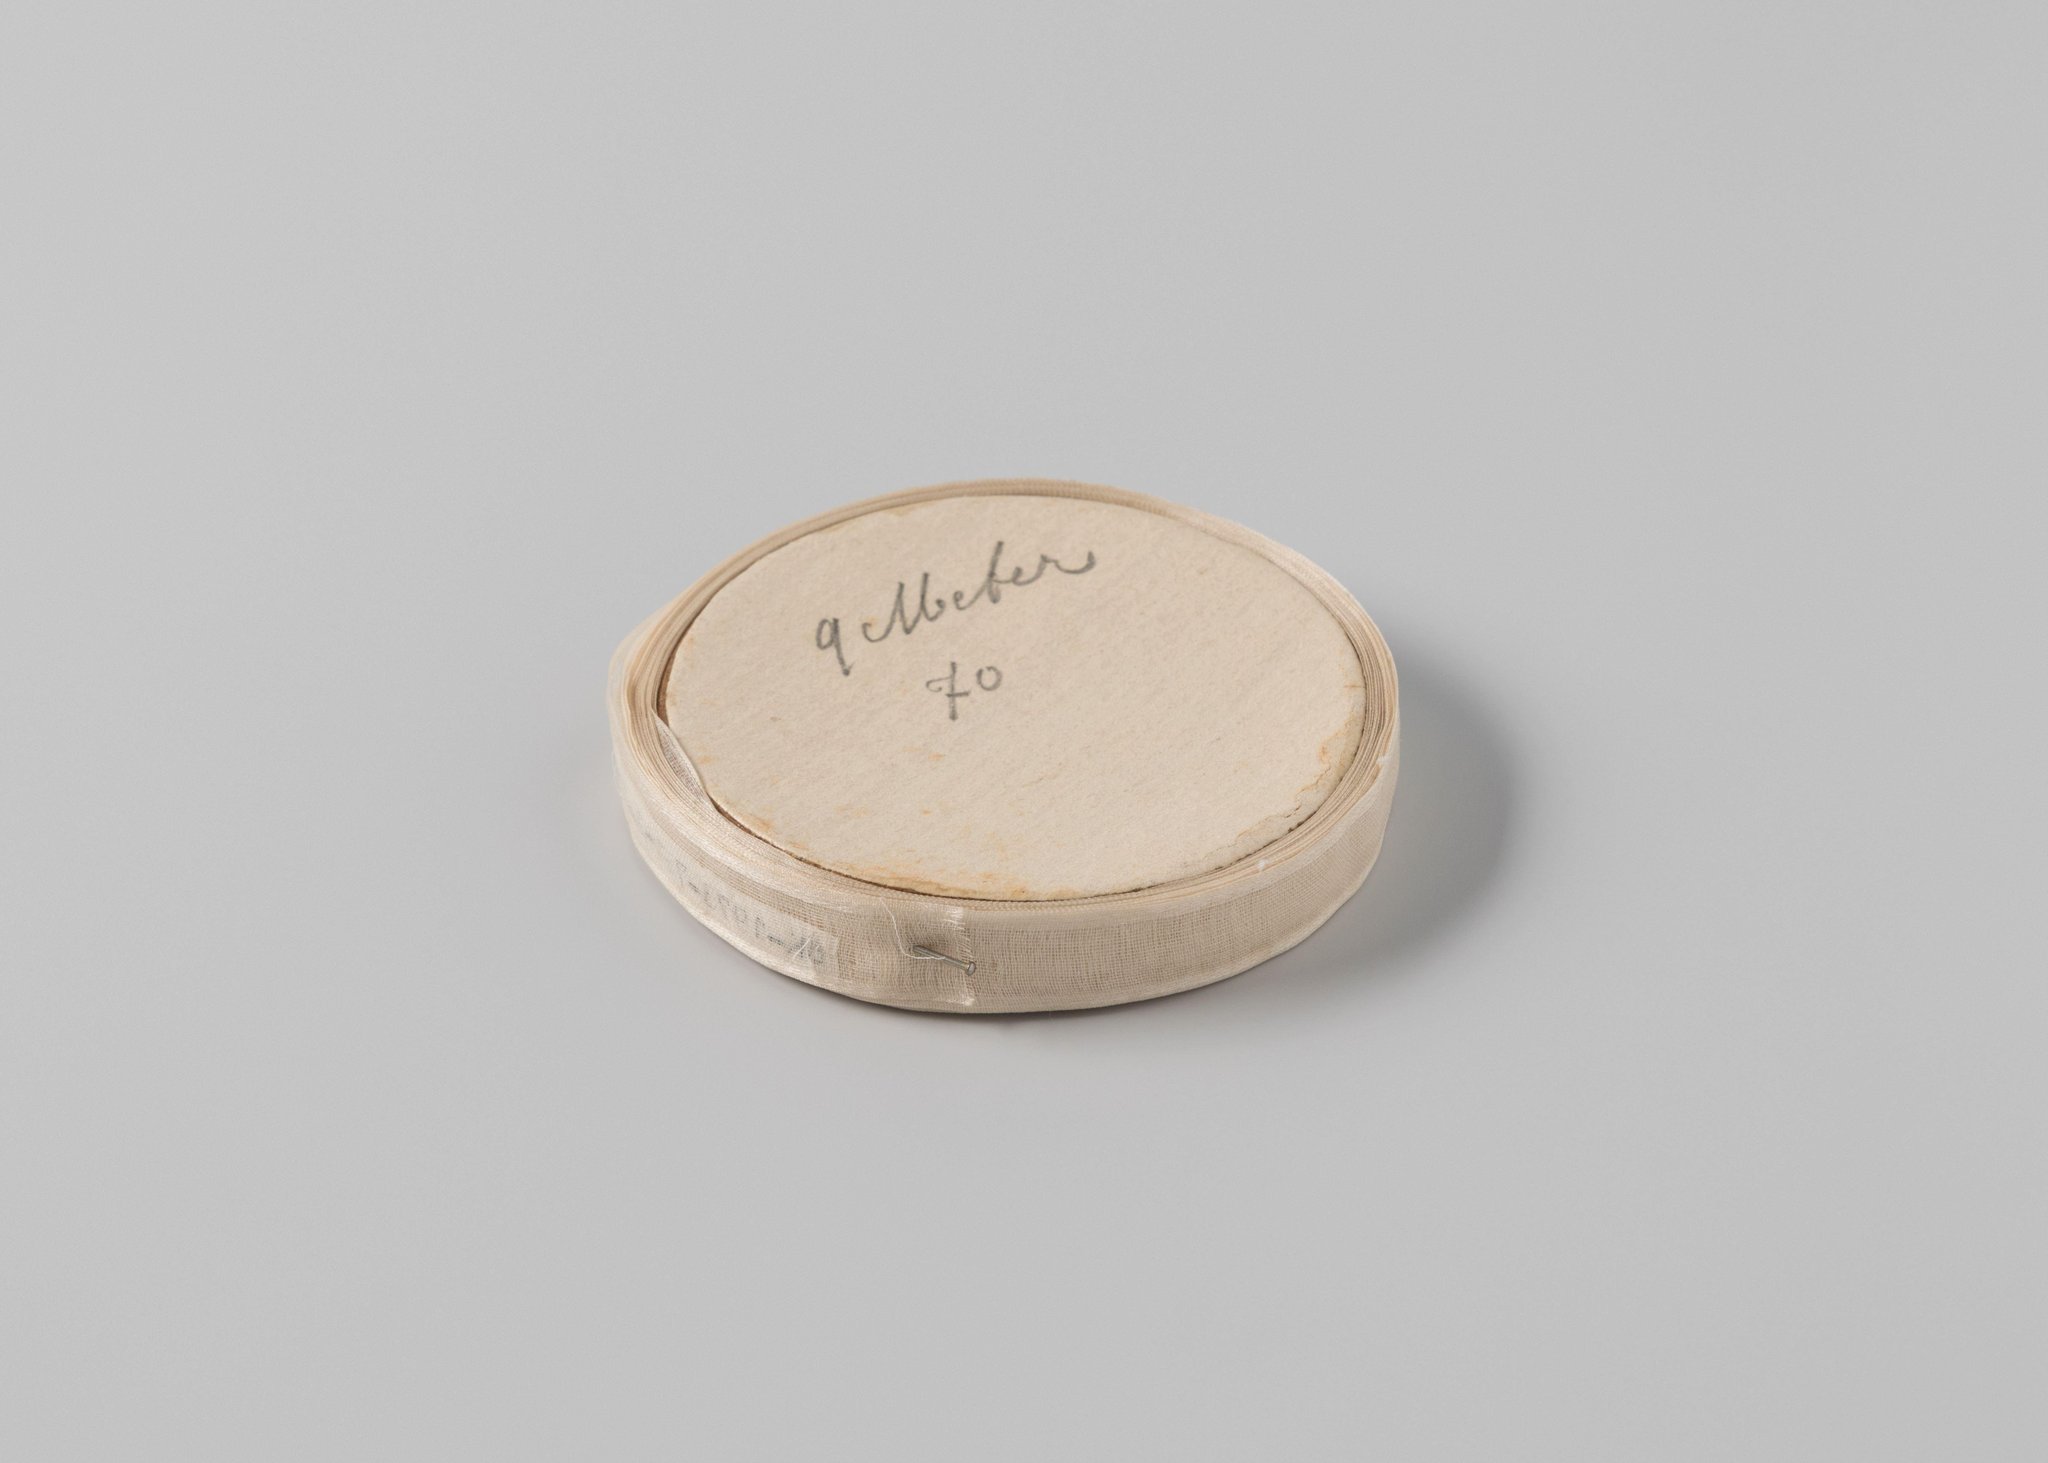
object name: ribbon material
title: Lint van crèmekleurig gaas van 9 meter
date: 1900-1915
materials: textile, silk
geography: nijmegen